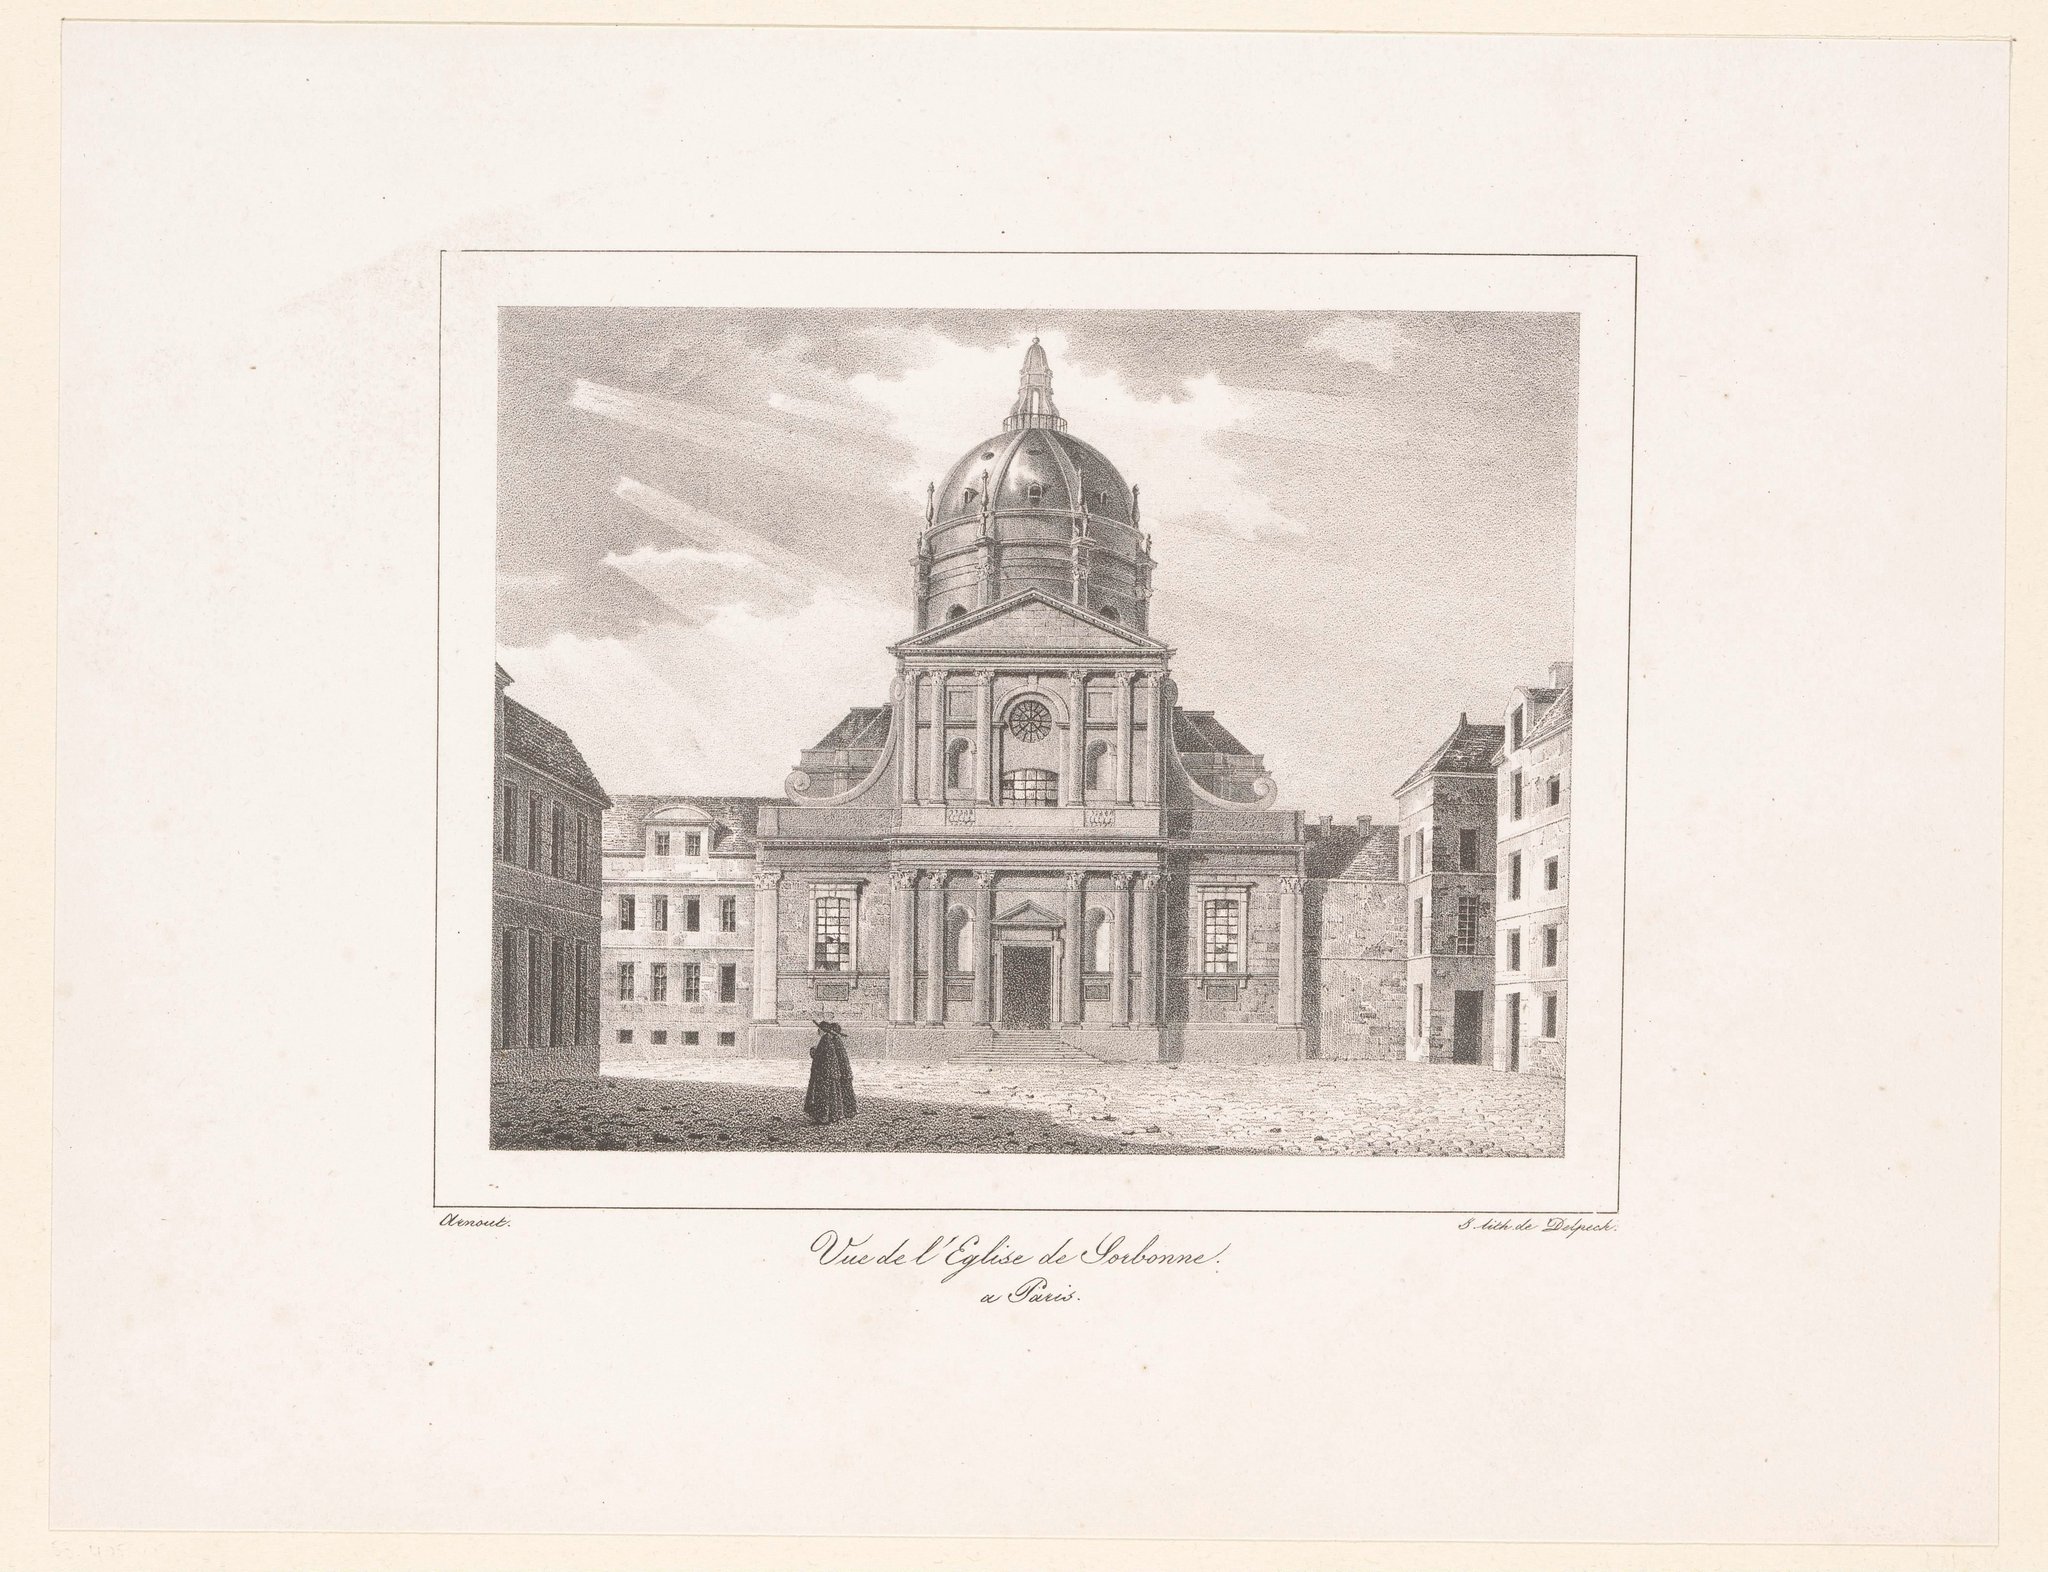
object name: print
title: Zicht op de Chapelle Sainte Ursule de la Sorbonne in Parijs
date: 1820-1821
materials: paper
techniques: lithograph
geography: paris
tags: church (exterior), dome ~ architecture, paris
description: De serie waar deze prent deel van uit maakt, bestaat waarschijnlijk uit dertig prenten.